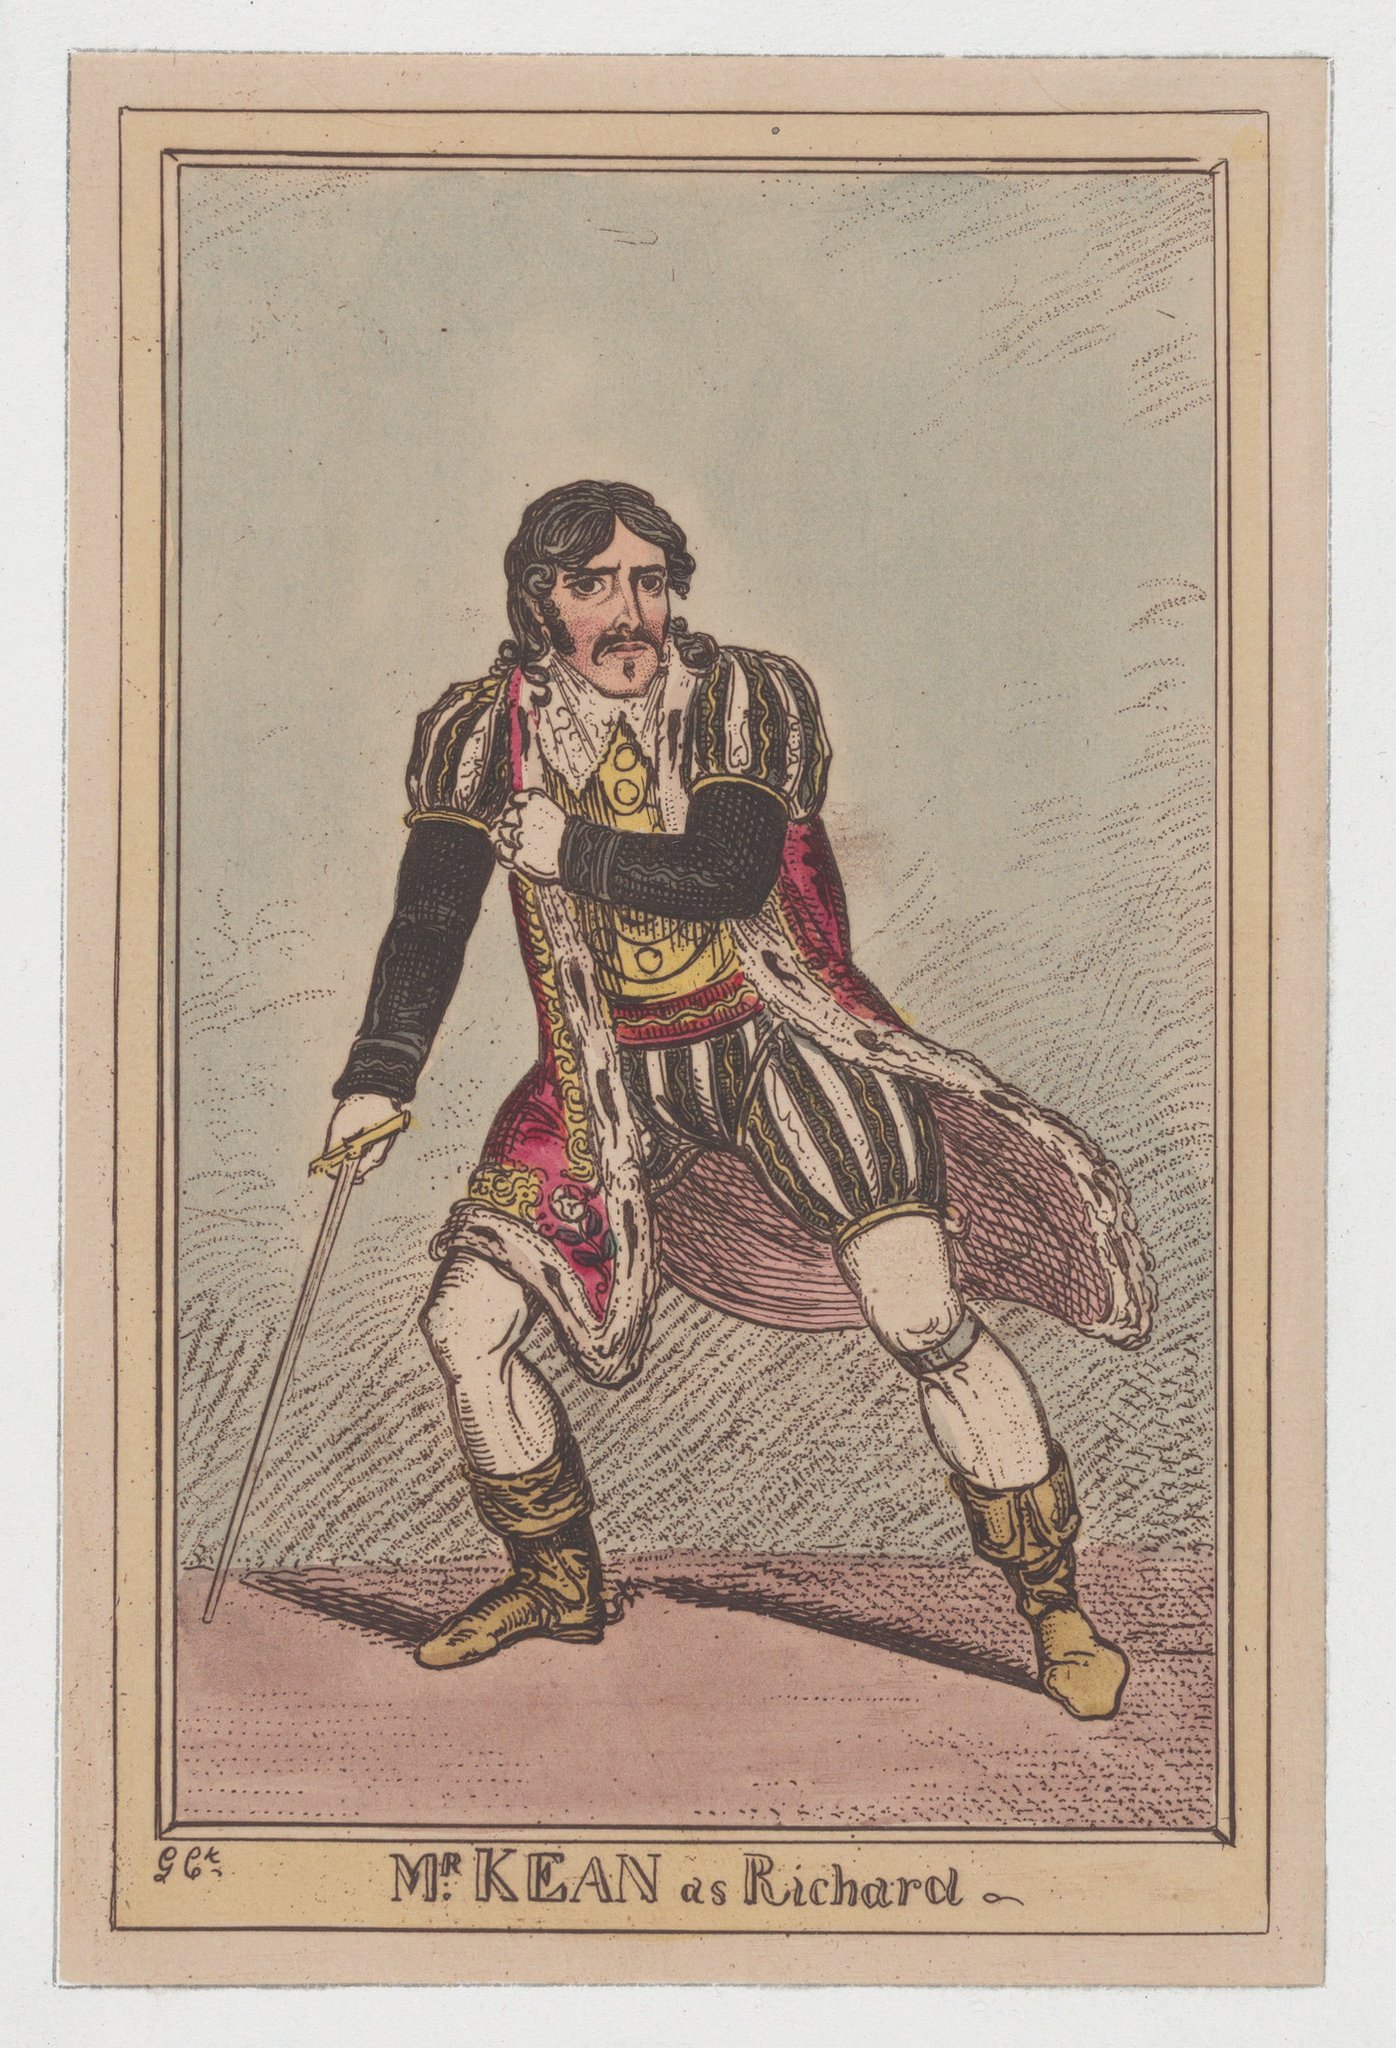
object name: print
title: Edmund Kean as Richard III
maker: george cruikshank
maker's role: artist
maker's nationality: british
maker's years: 1792-1878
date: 1814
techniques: etching, hand coloring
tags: shakespeare,men,actresses